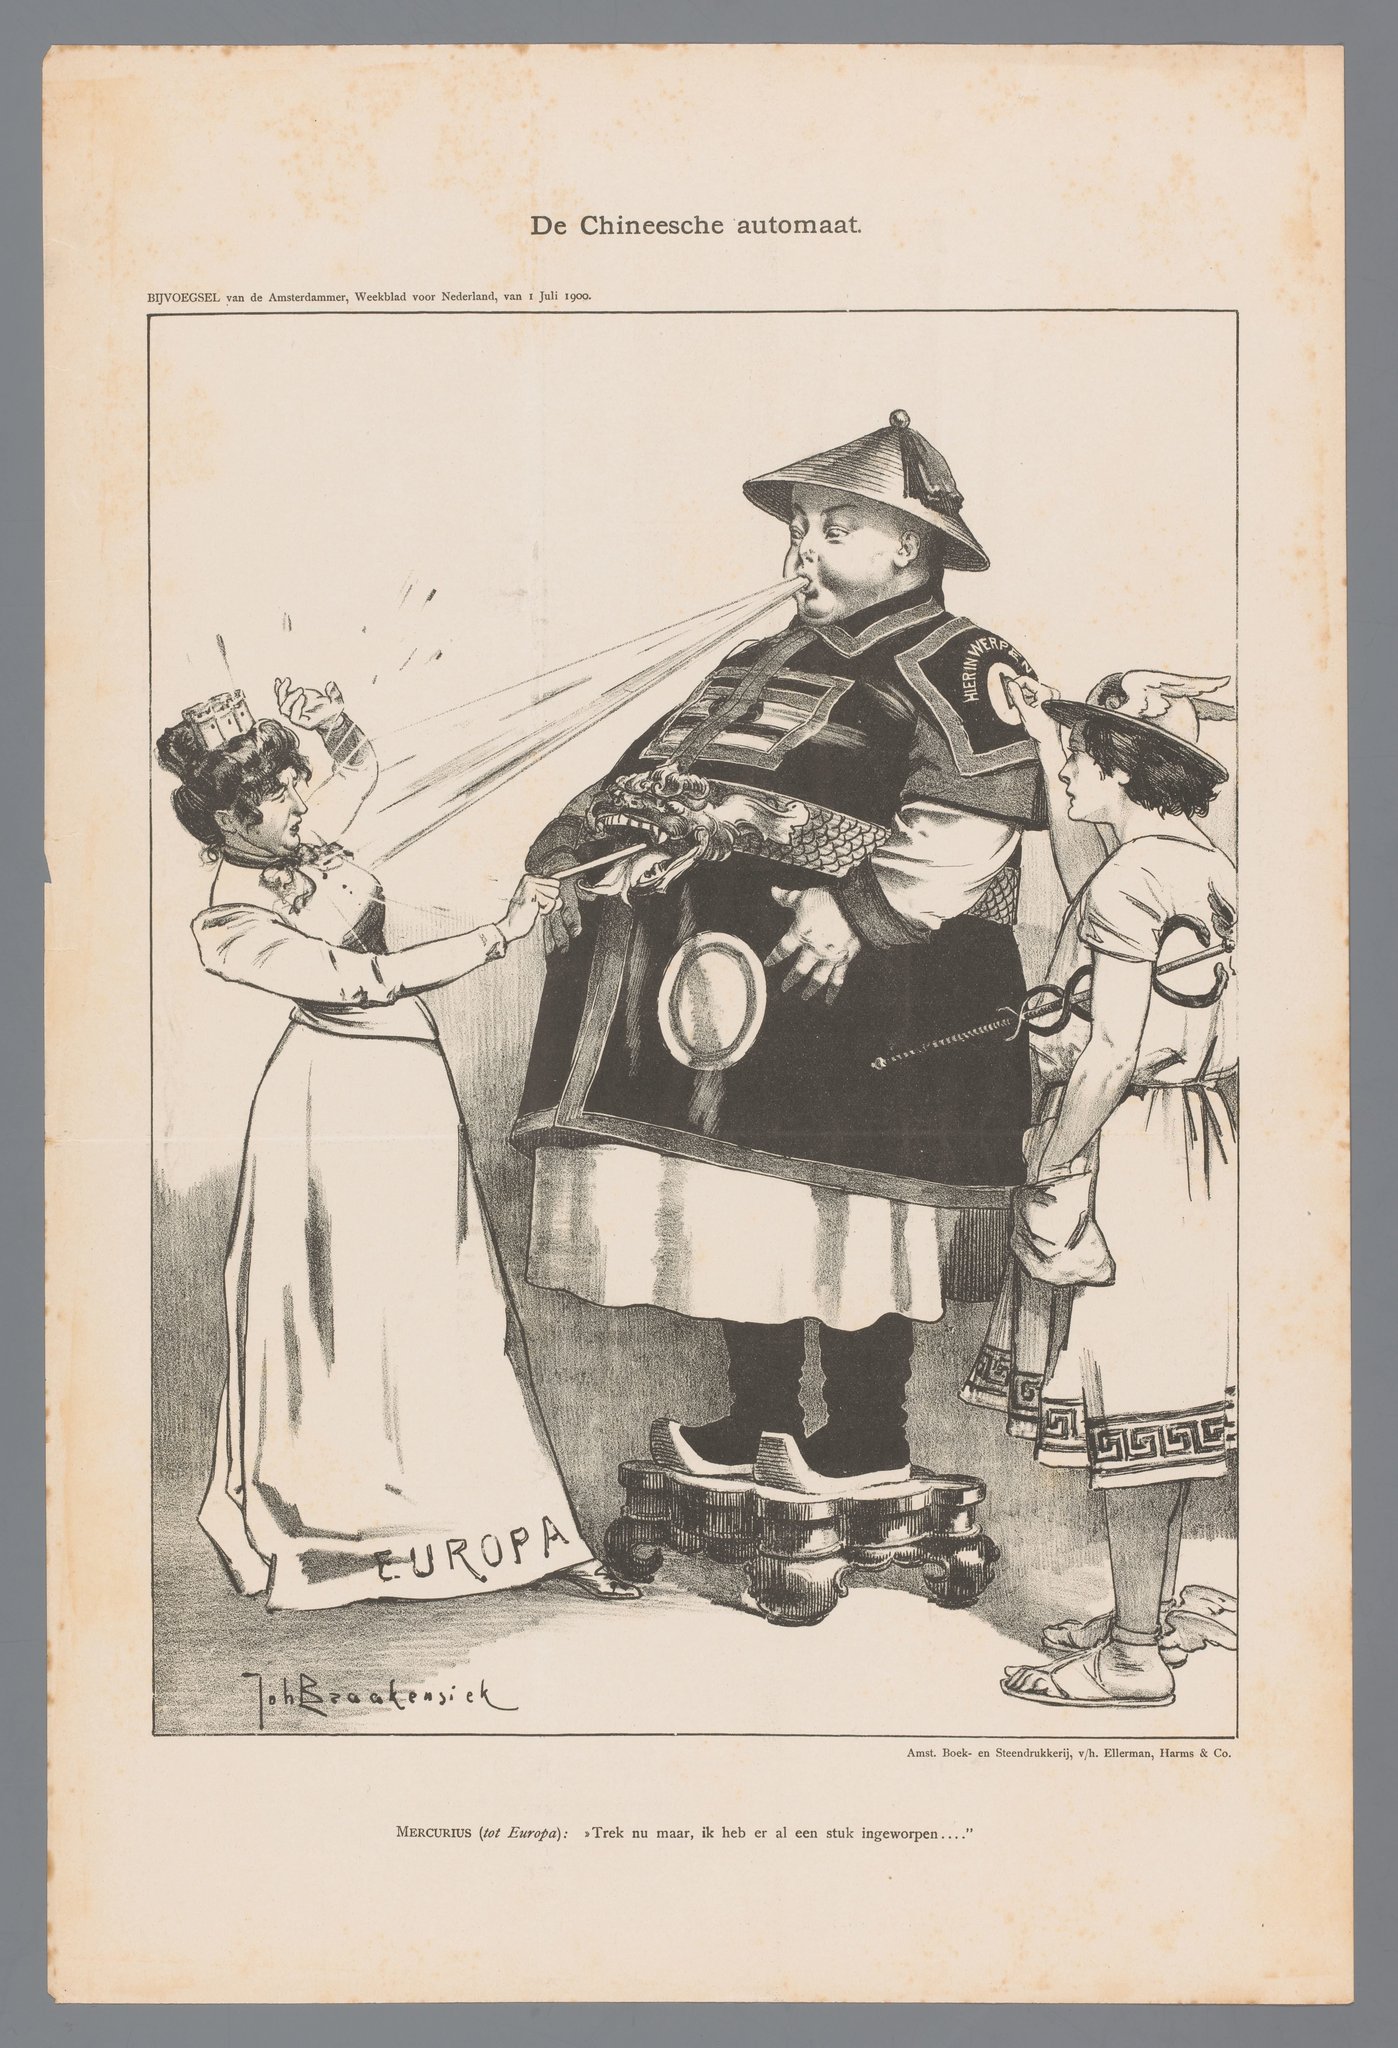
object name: cartoon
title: De Chineesche automaat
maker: johan braakensiek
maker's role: draughtsman, print maker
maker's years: 1858-1940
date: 1900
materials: paper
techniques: lithograph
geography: amsterdam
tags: europe represented allegorically; 'europa' (ripa), personifications of countries, nations, states, districts, etc., (story of) mercury (hermes), political caricatures and satires, china, europe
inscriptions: date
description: Prent uit het bijvoegsel van: De Amsterdammer. Weekblad voor Nederland, 1 juli 1900.